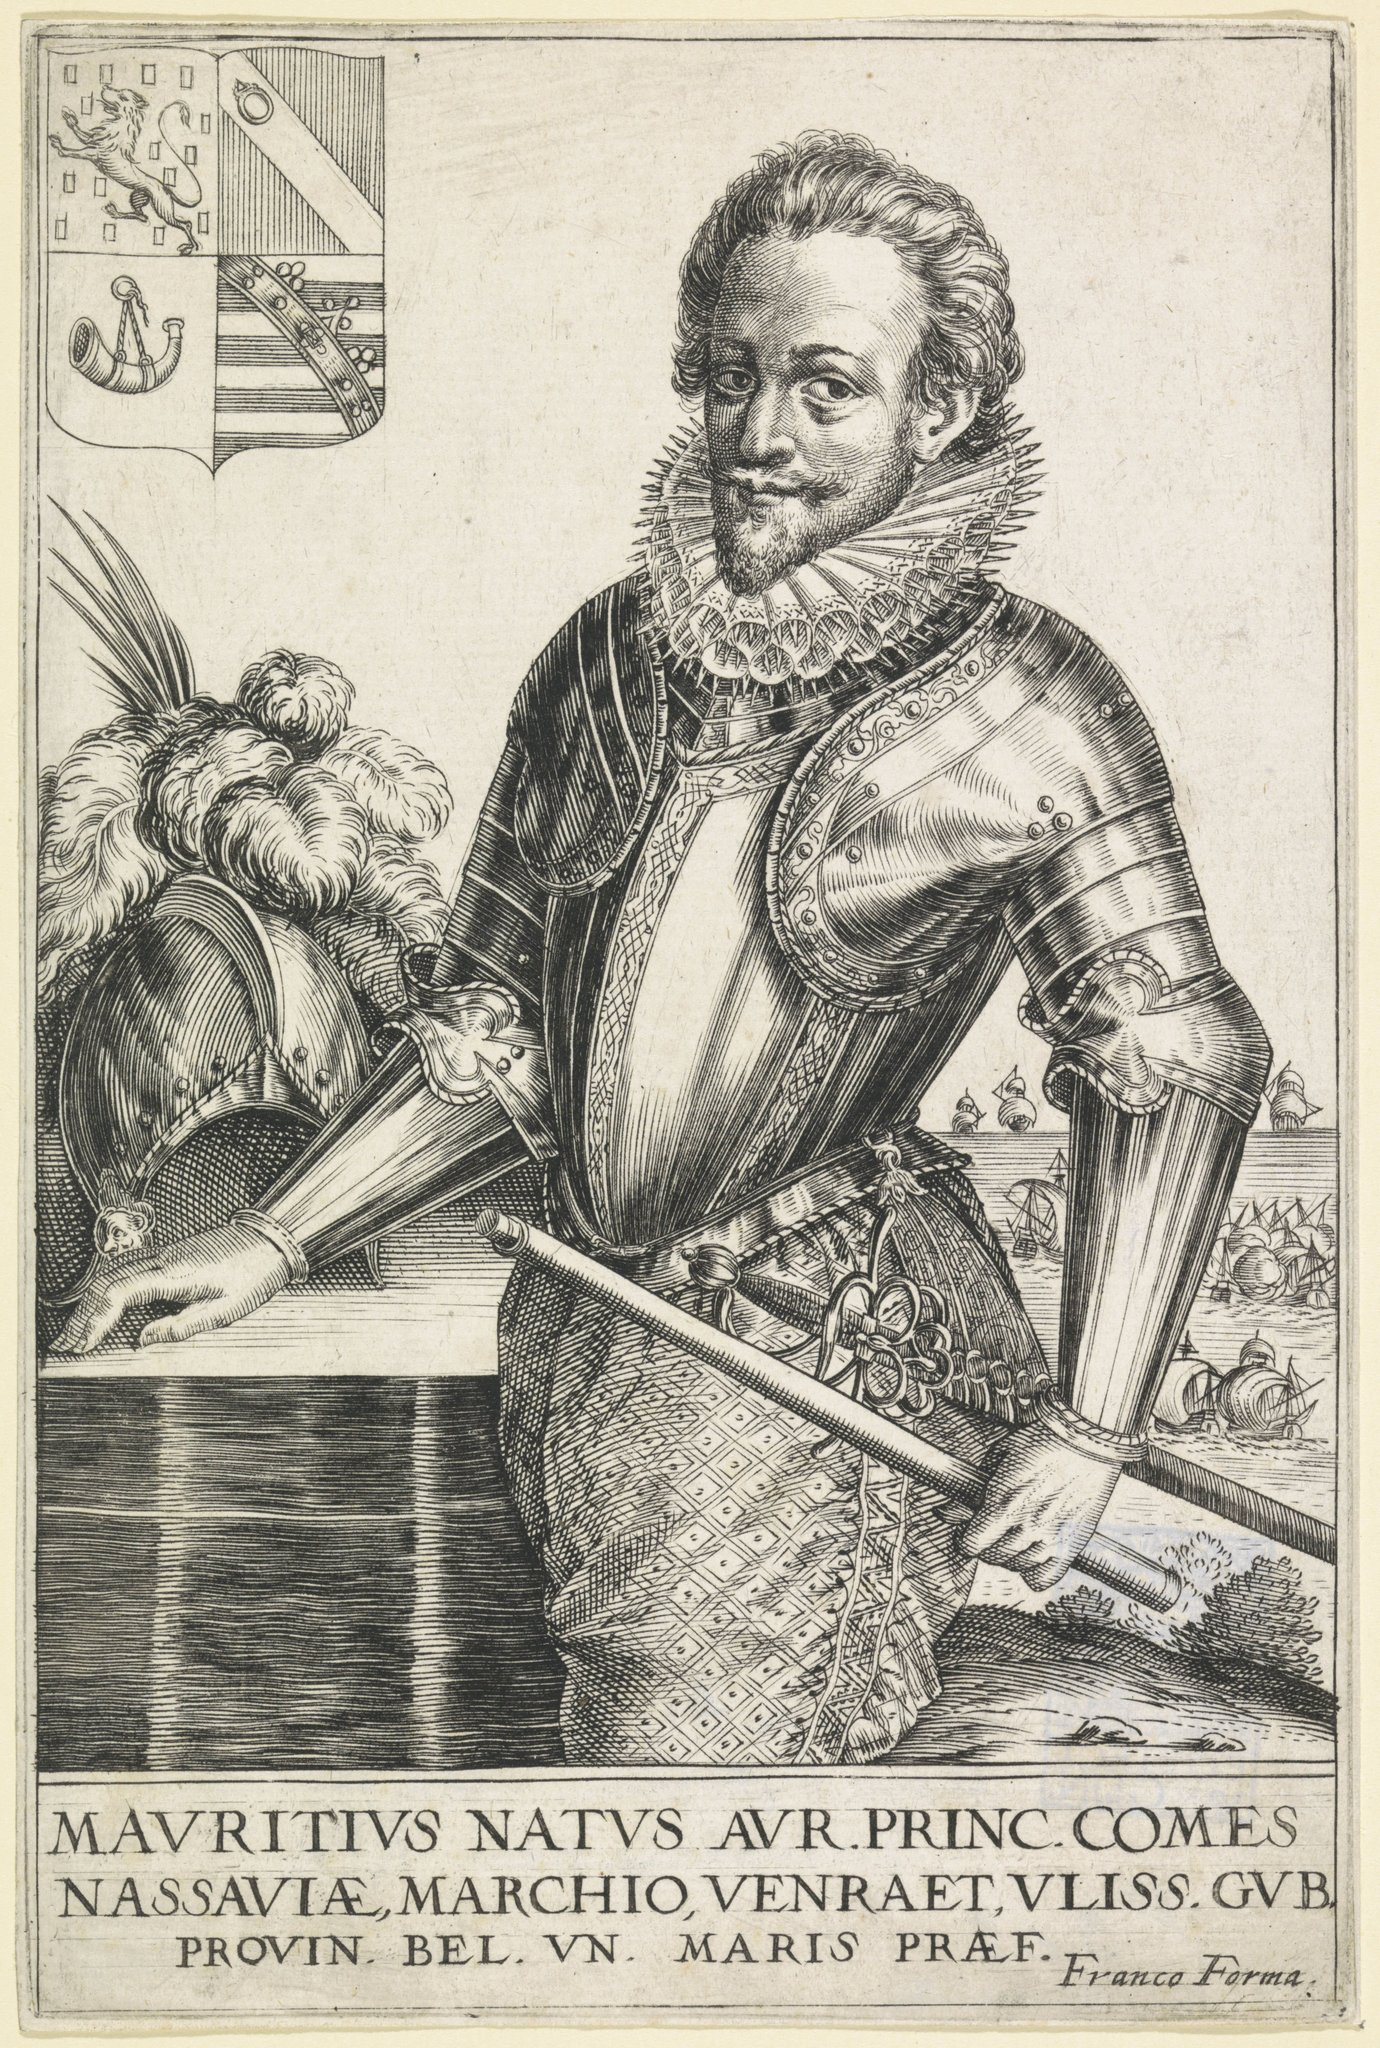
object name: print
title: Portret van Maurits, prins van Oranje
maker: Anonymous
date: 1600-1699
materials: paper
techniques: engraving, etching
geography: low countries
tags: the hague, maurice (prince of orange)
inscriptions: collector's mark: Lugt 1118a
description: Portret van Maurits met links zijn wapen. Hij staat naast een tafel met daarop de helm van zijn harnas. Hij houdt een commandostaf in de hand. Op de achtergrond een zeeslag. In een kader zijn naam.